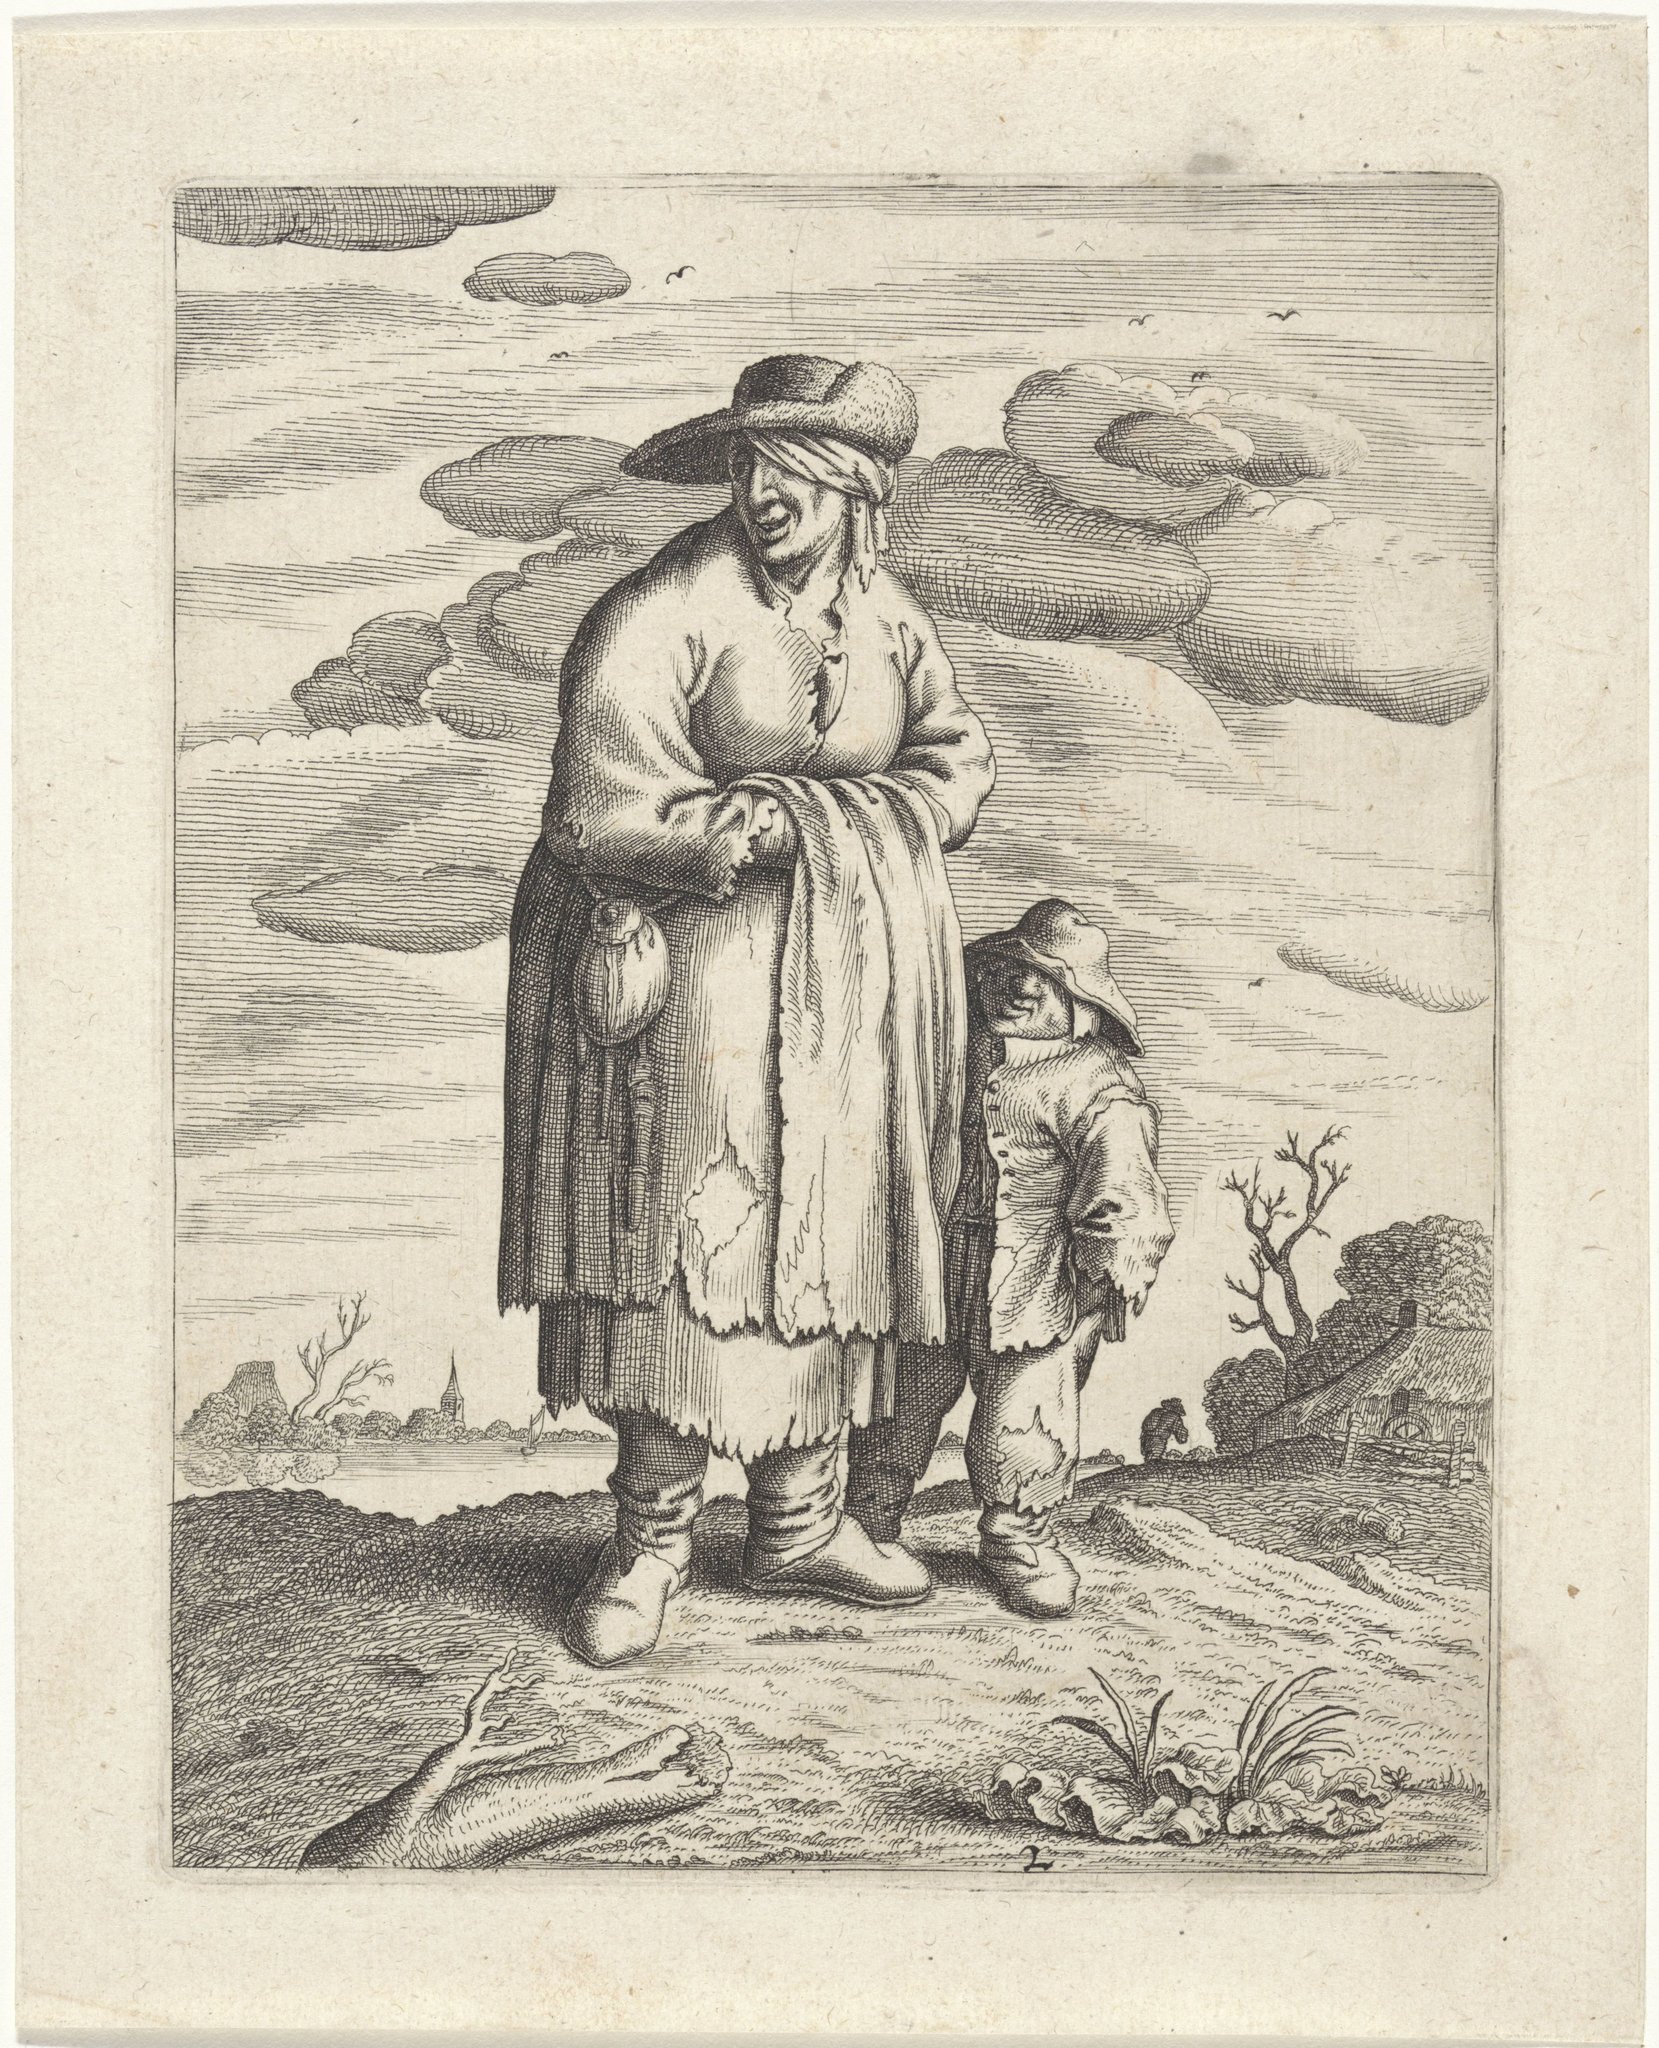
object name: print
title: Boeren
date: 1656-1690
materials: paper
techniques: etching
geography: amsterdam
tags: river, boy (child between toddler and youth), farmers - aa - female farmer, farmer's wife, farm (building)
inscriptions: collector's mark: Lugt 240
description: In een rivierlandschap staat een in lompen gehulde boerin naast een jongen. Rechtsachter ligt een boerderij. Linksachter, op de andere rivieroever, nog een boerderij en een kerk.